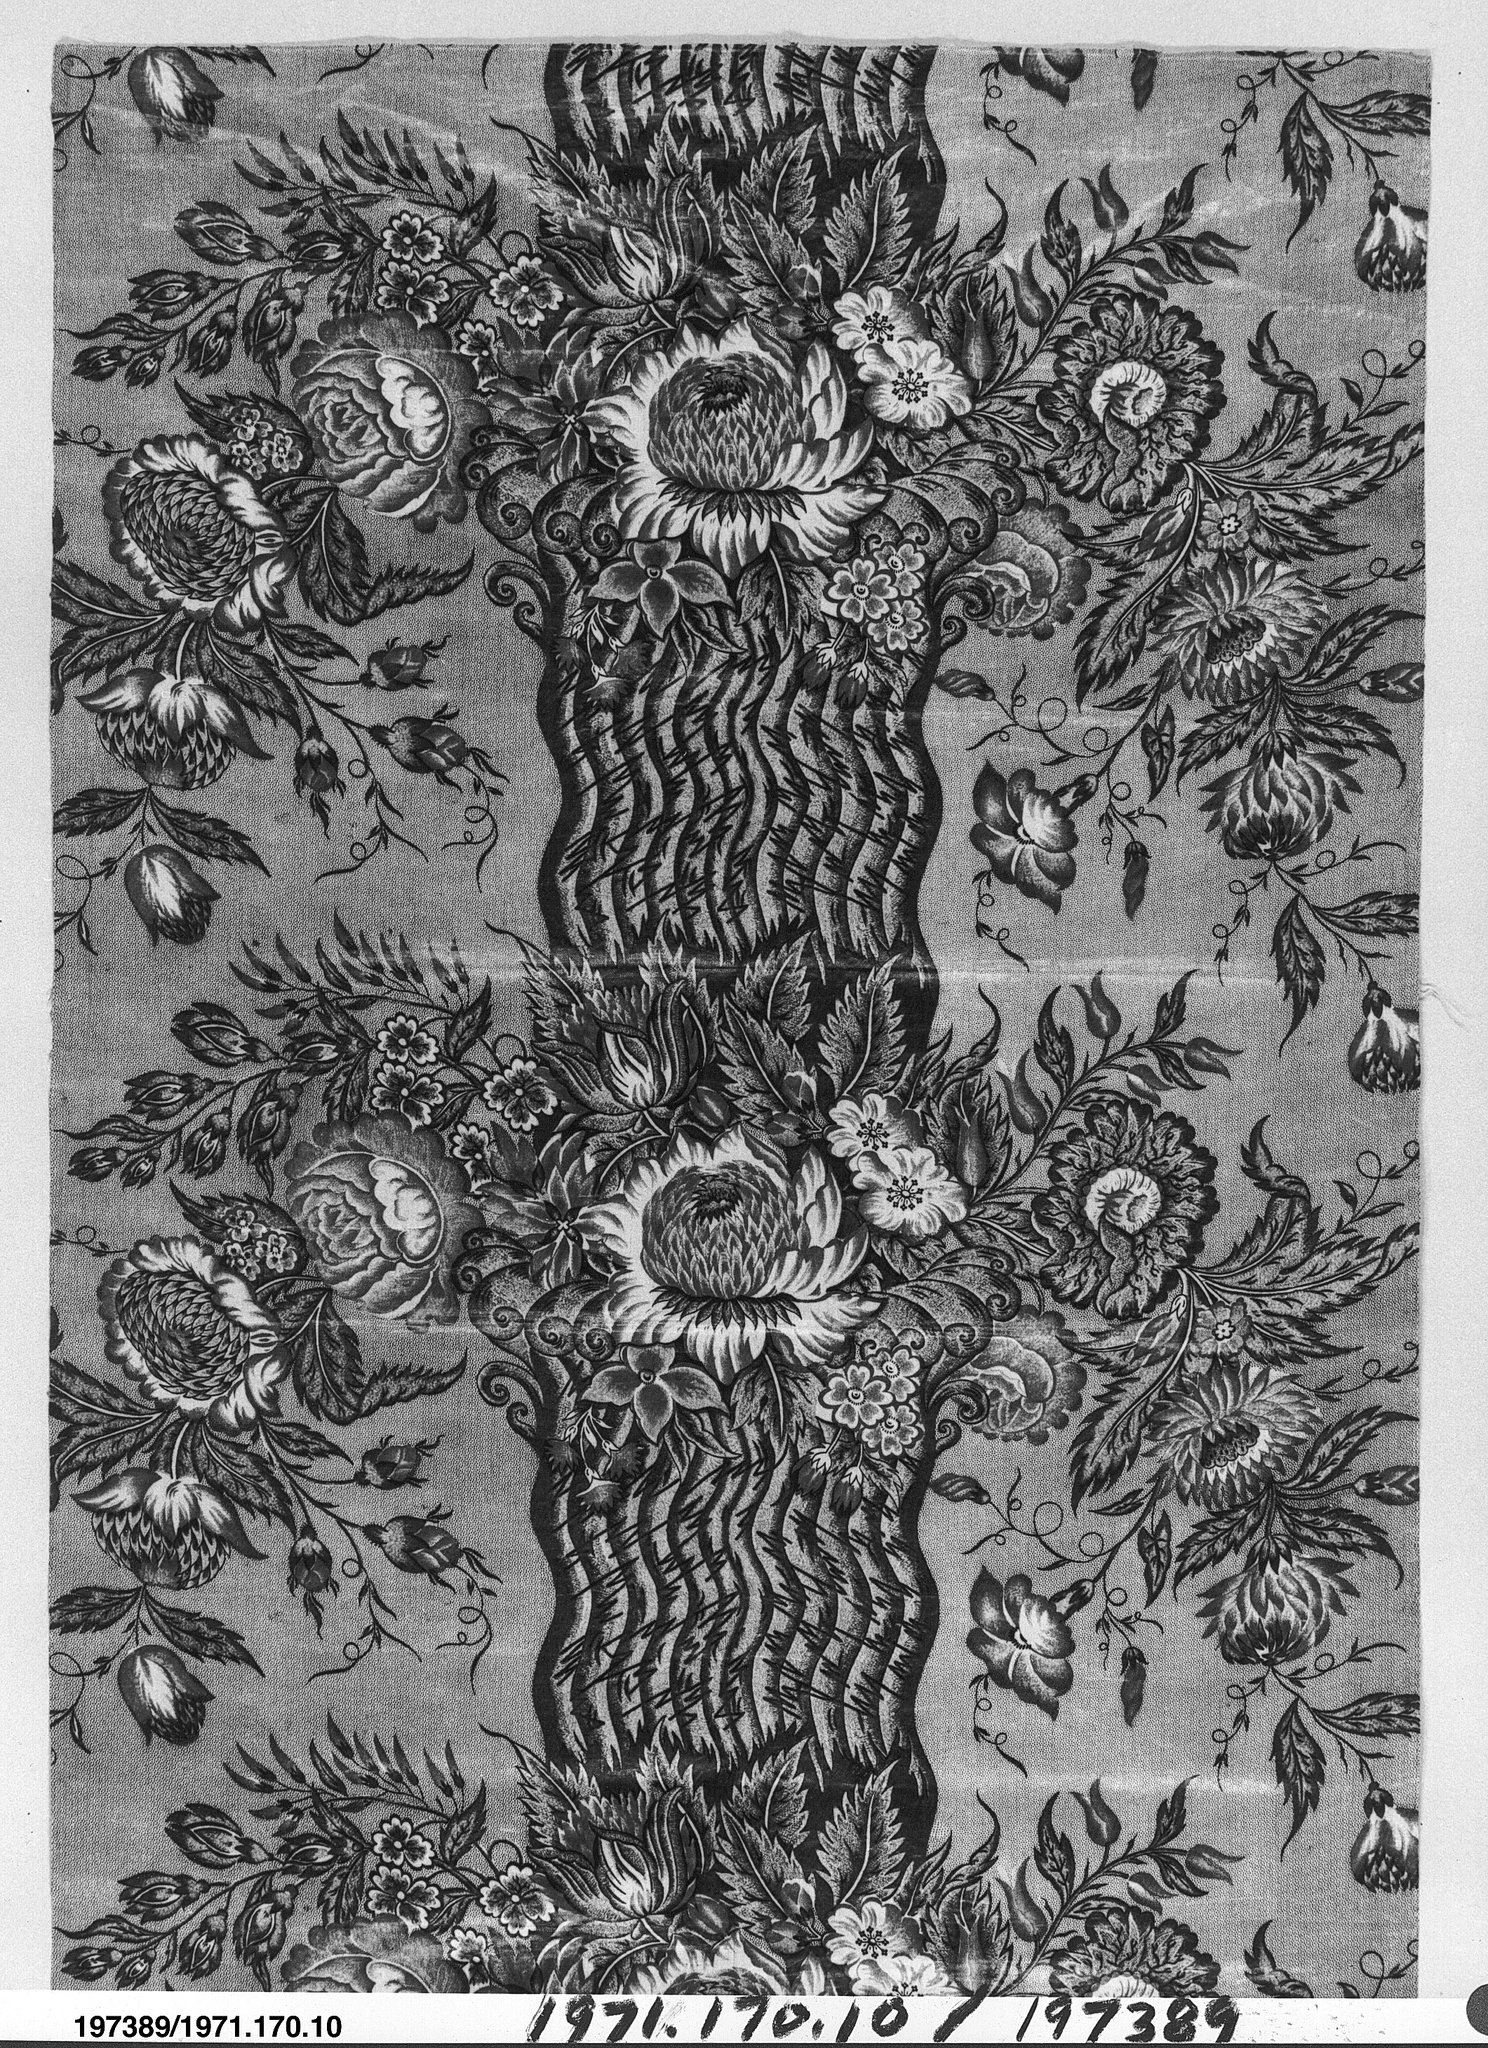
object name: piece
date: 1825-1835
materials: cotton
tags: flowers,leaves